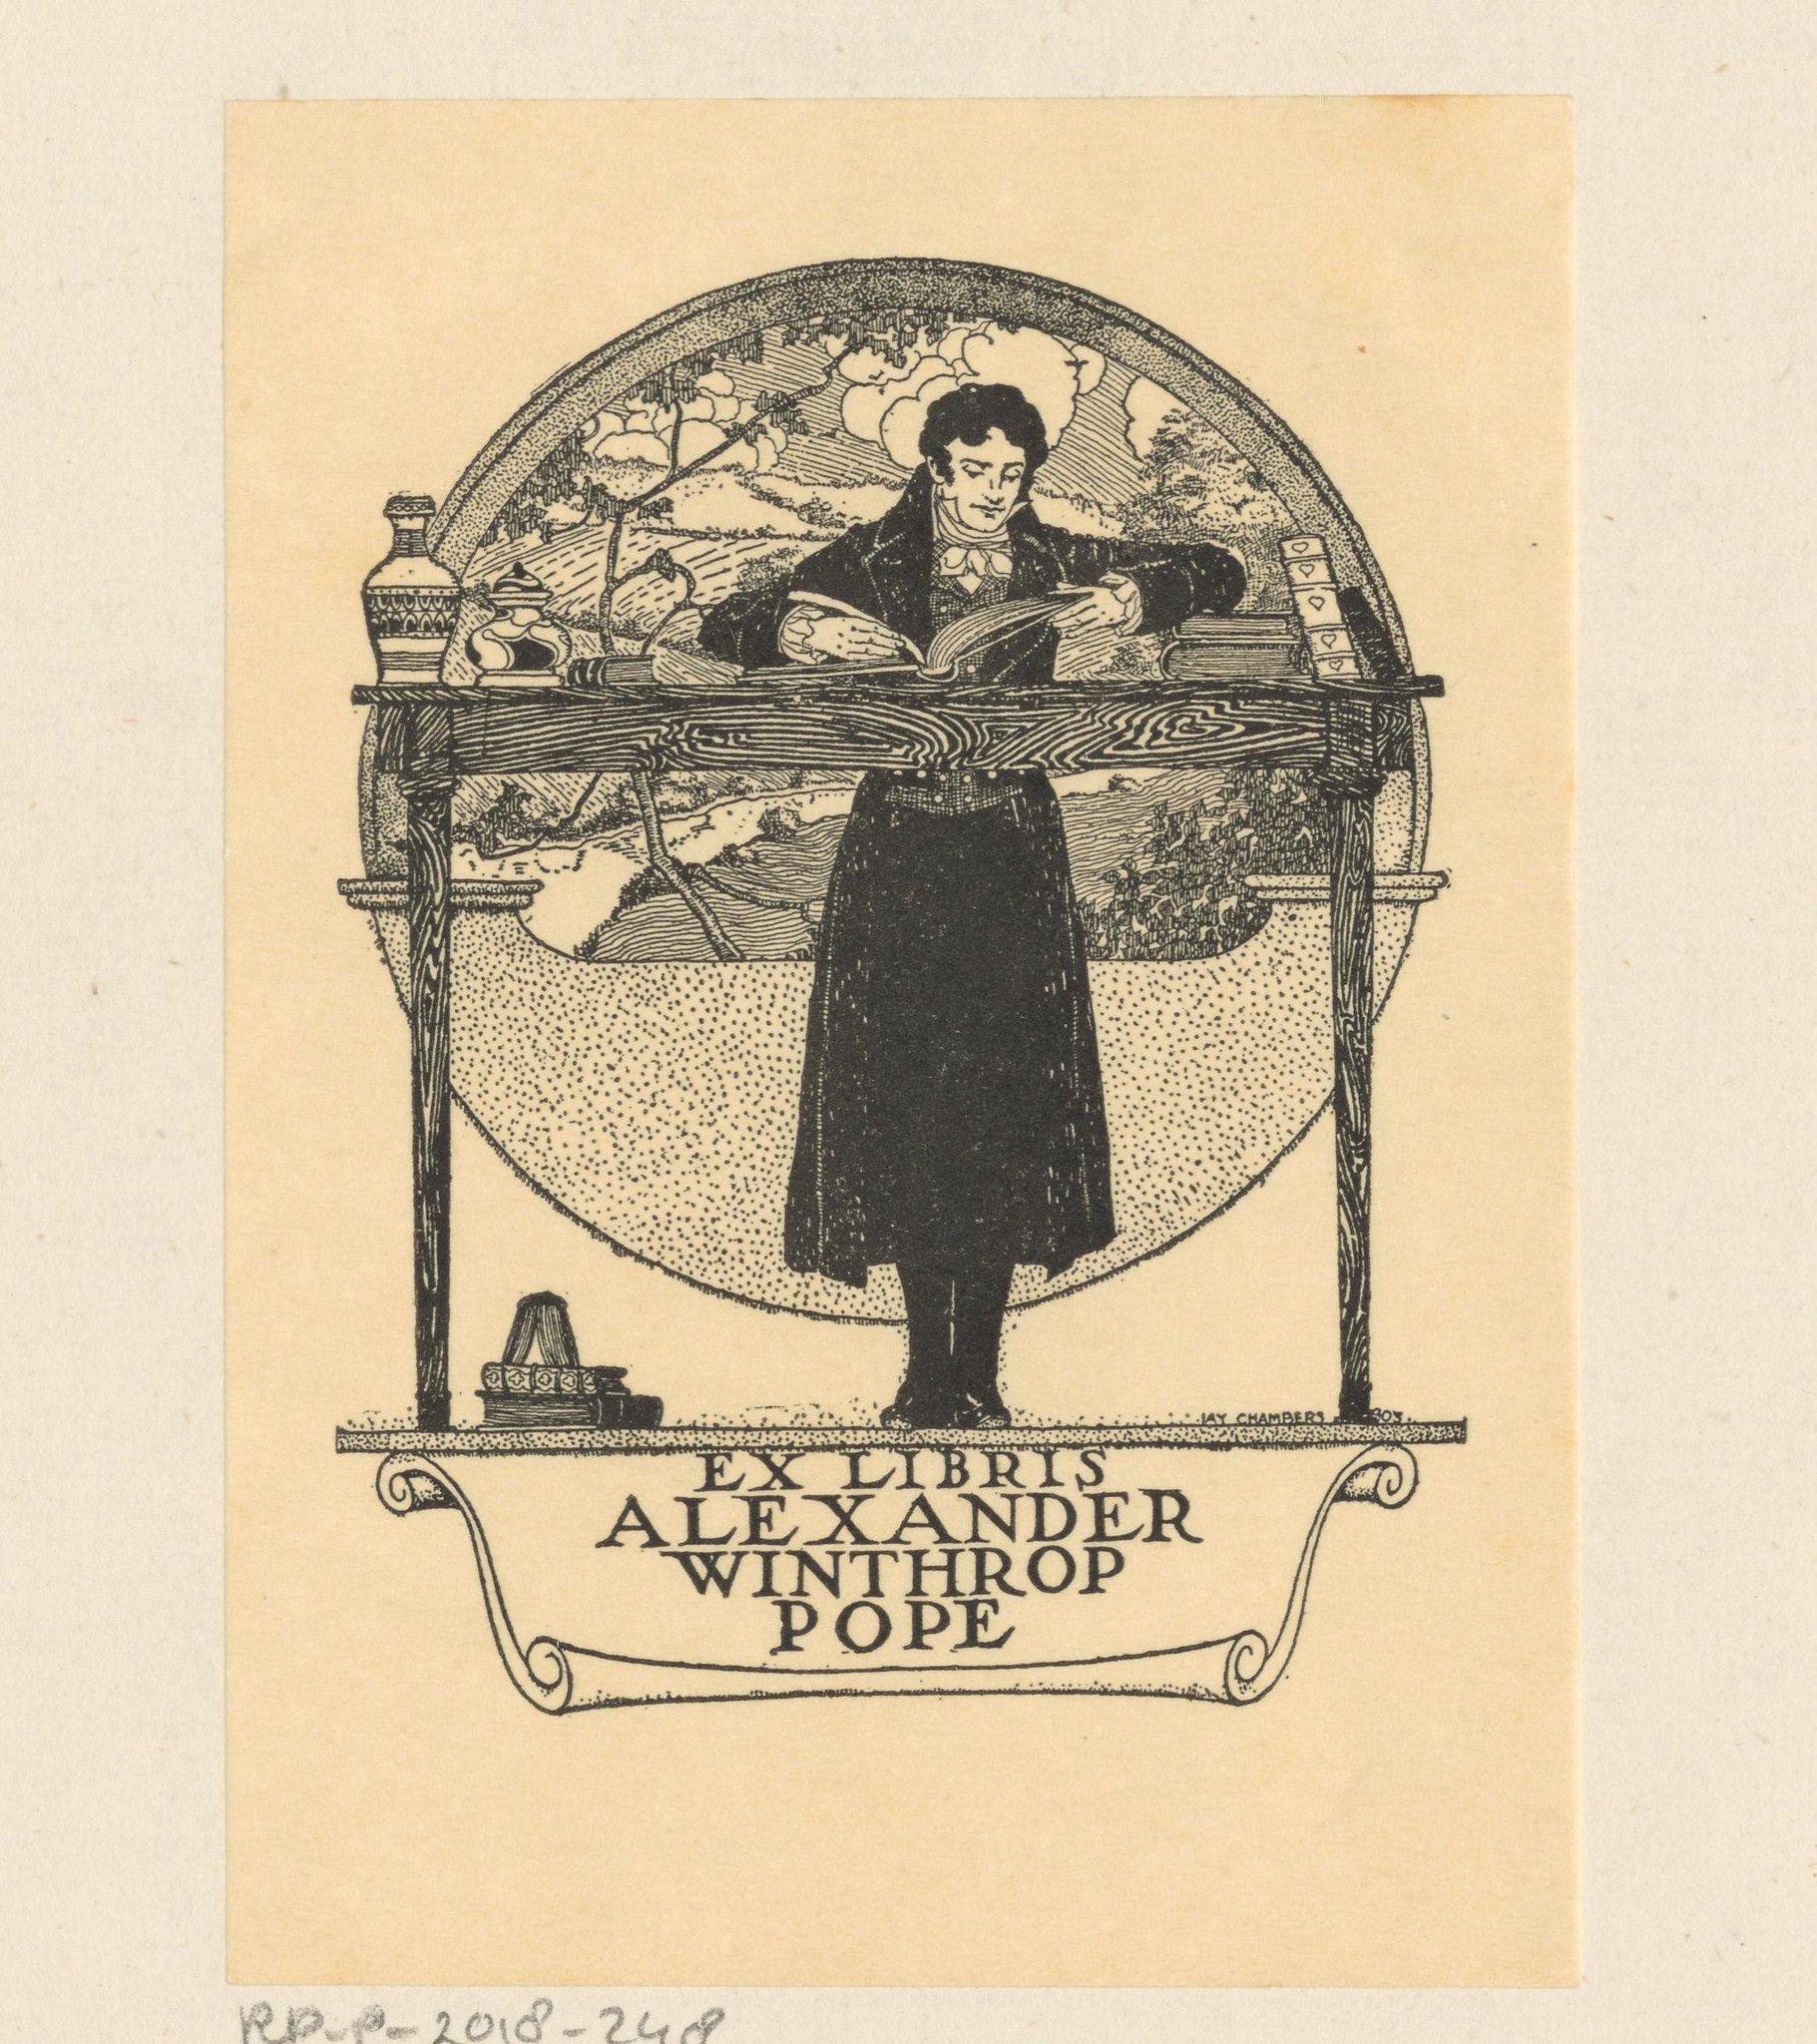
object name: bookplate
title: Ex libris van Alexander Winthrop Pope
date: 1903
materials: paper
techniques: printing block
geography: england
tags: standing figure, landscapes, historical costume, book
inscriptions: date